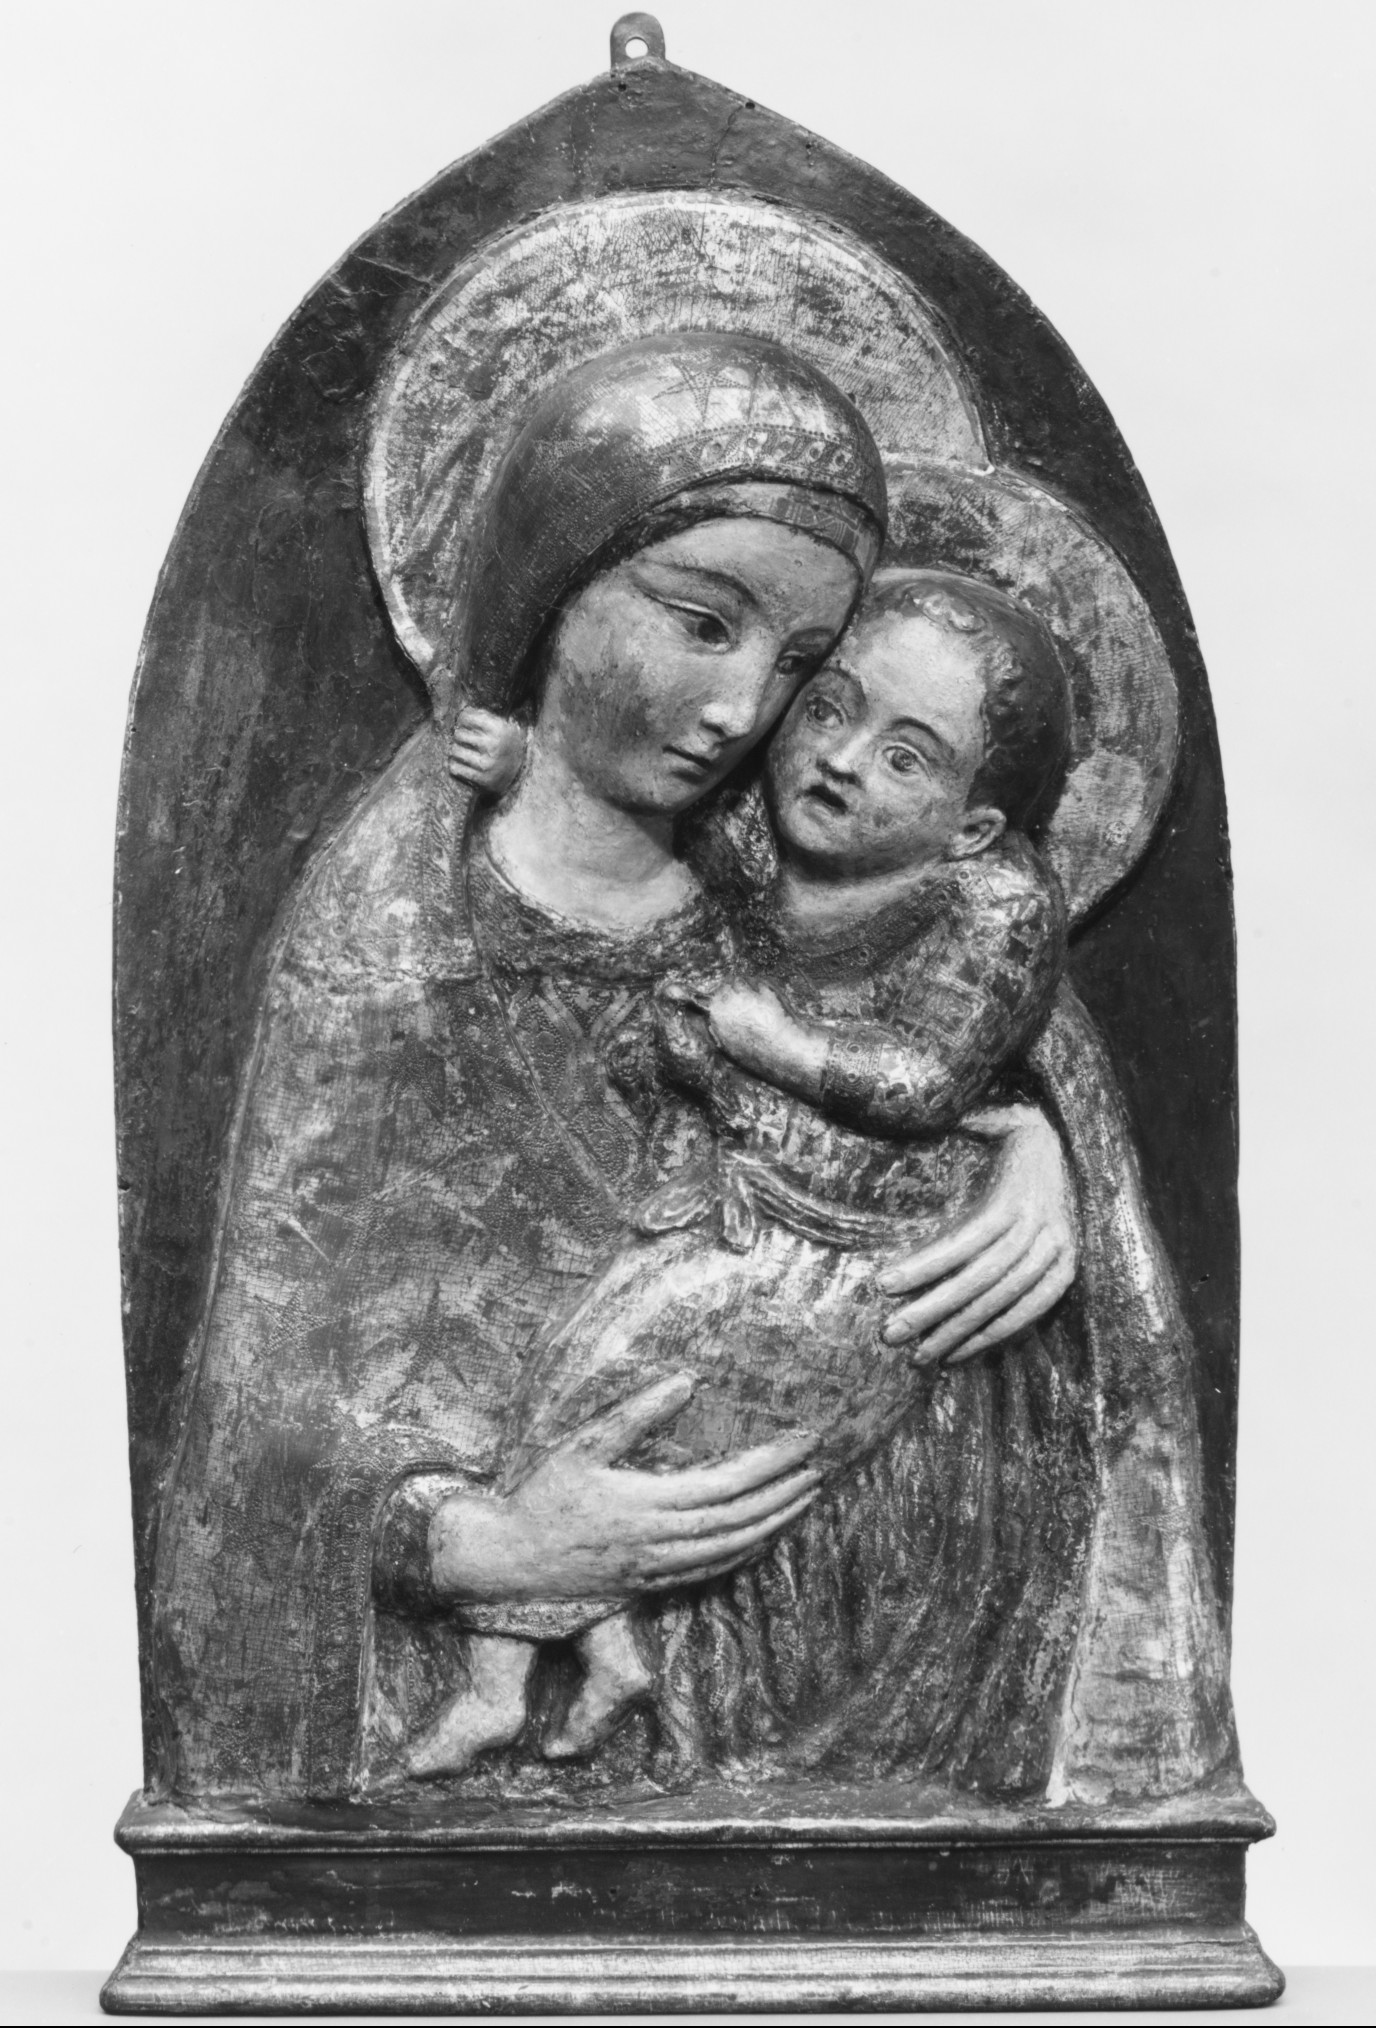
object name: relief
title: Madonna and Child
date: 1425-1450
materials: terracotta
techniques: gilding, painting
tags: madonna and child